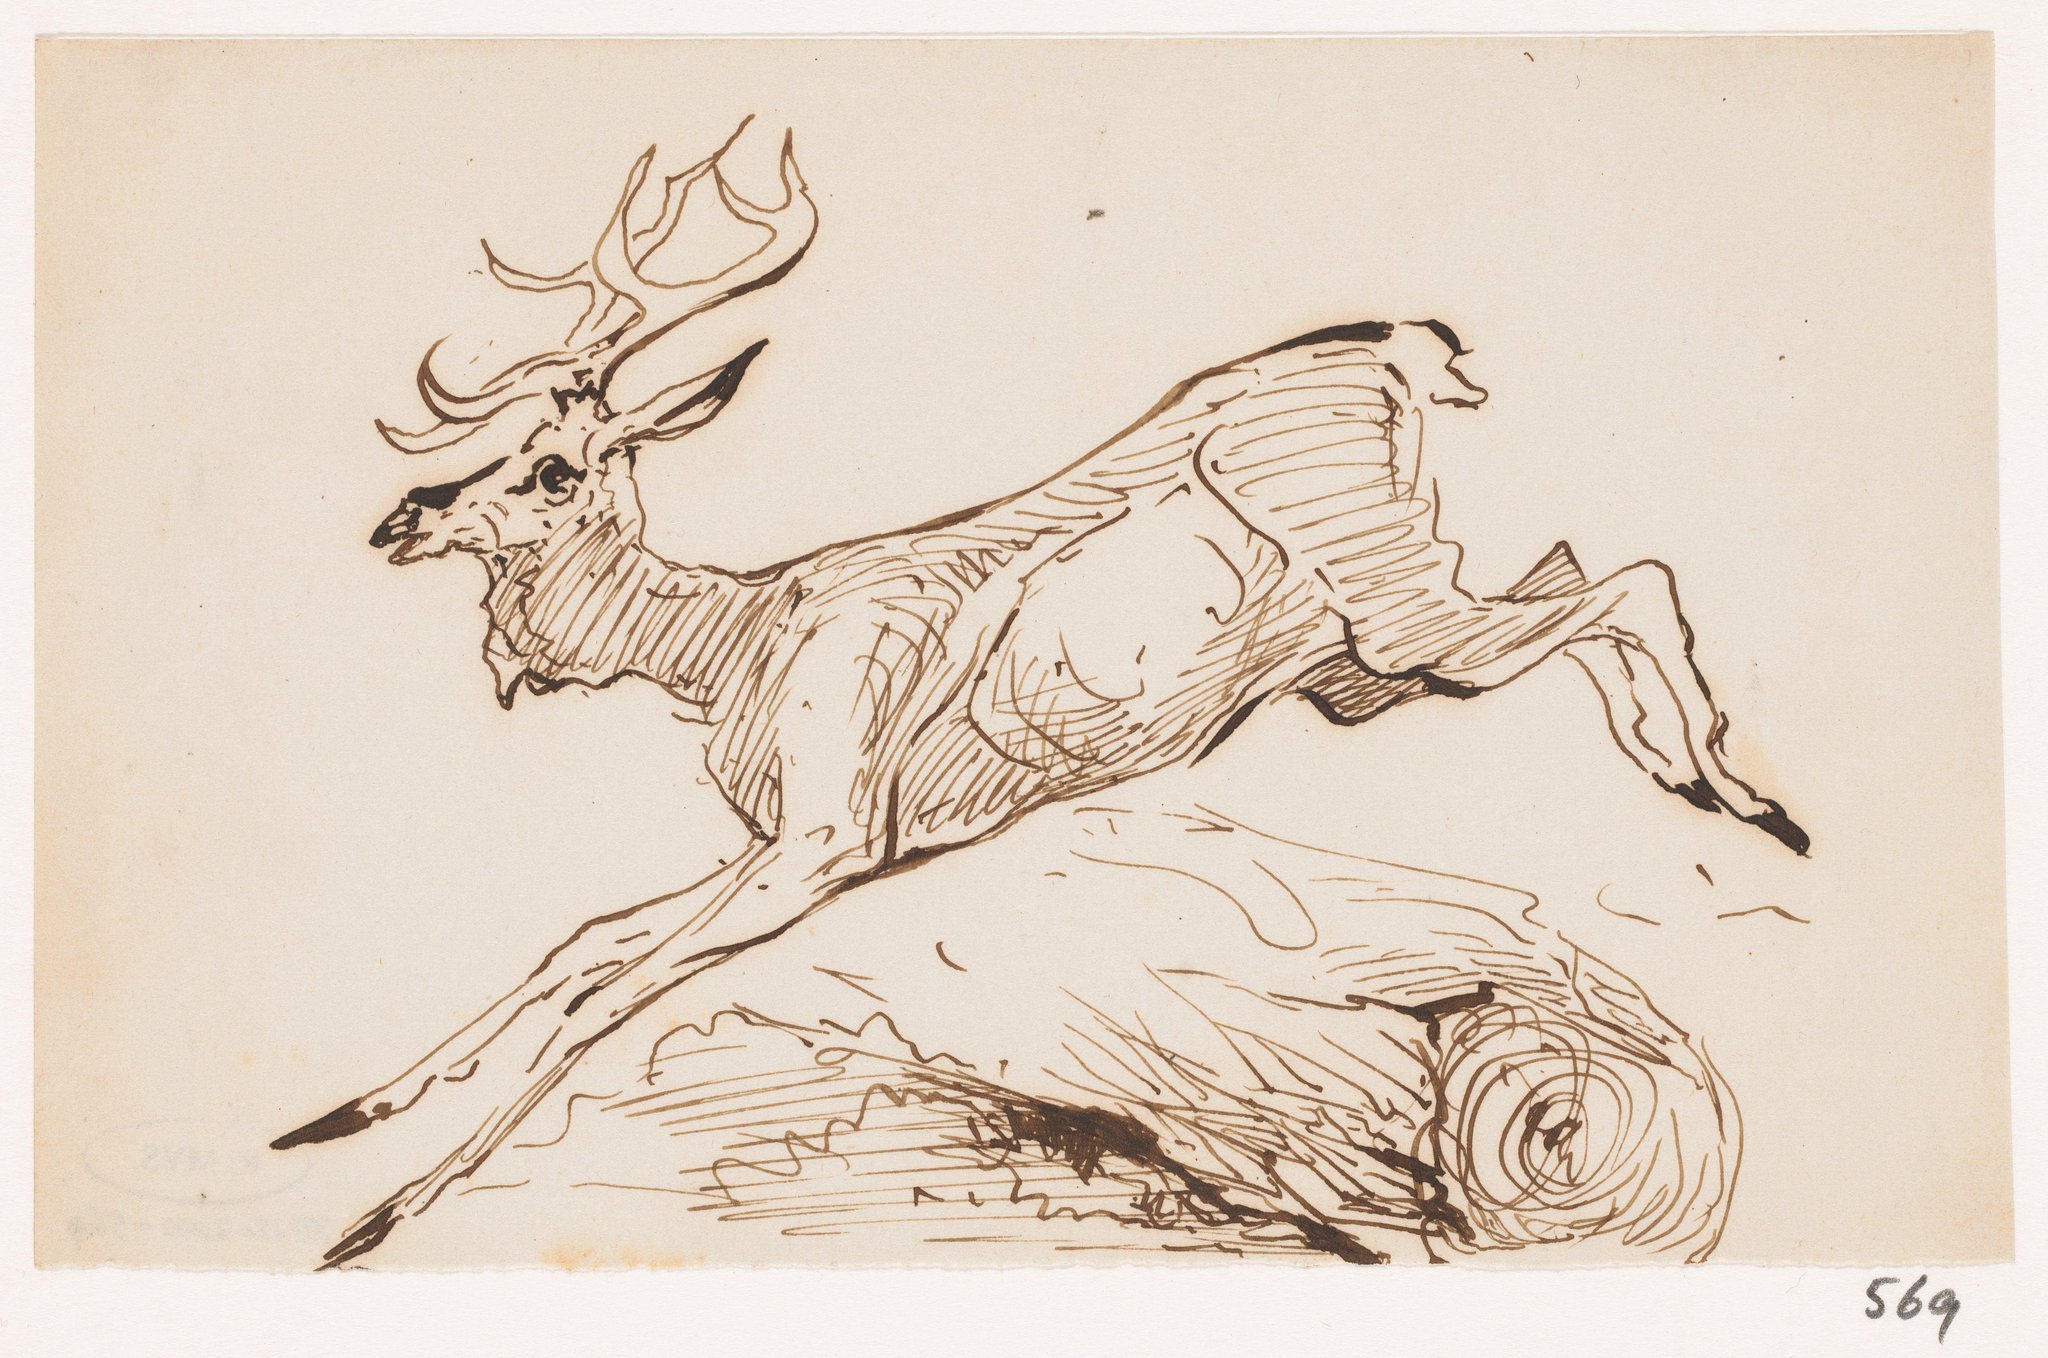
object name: drawing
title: Hert springt over boomstam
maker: johannes tavenraat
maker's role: draughtsman, painter, print maker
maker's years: 1809-1881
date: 1840-1880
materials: ink, paper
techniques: pen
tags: hoofed animals: deer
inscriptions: collector's mark: Lugt 2228